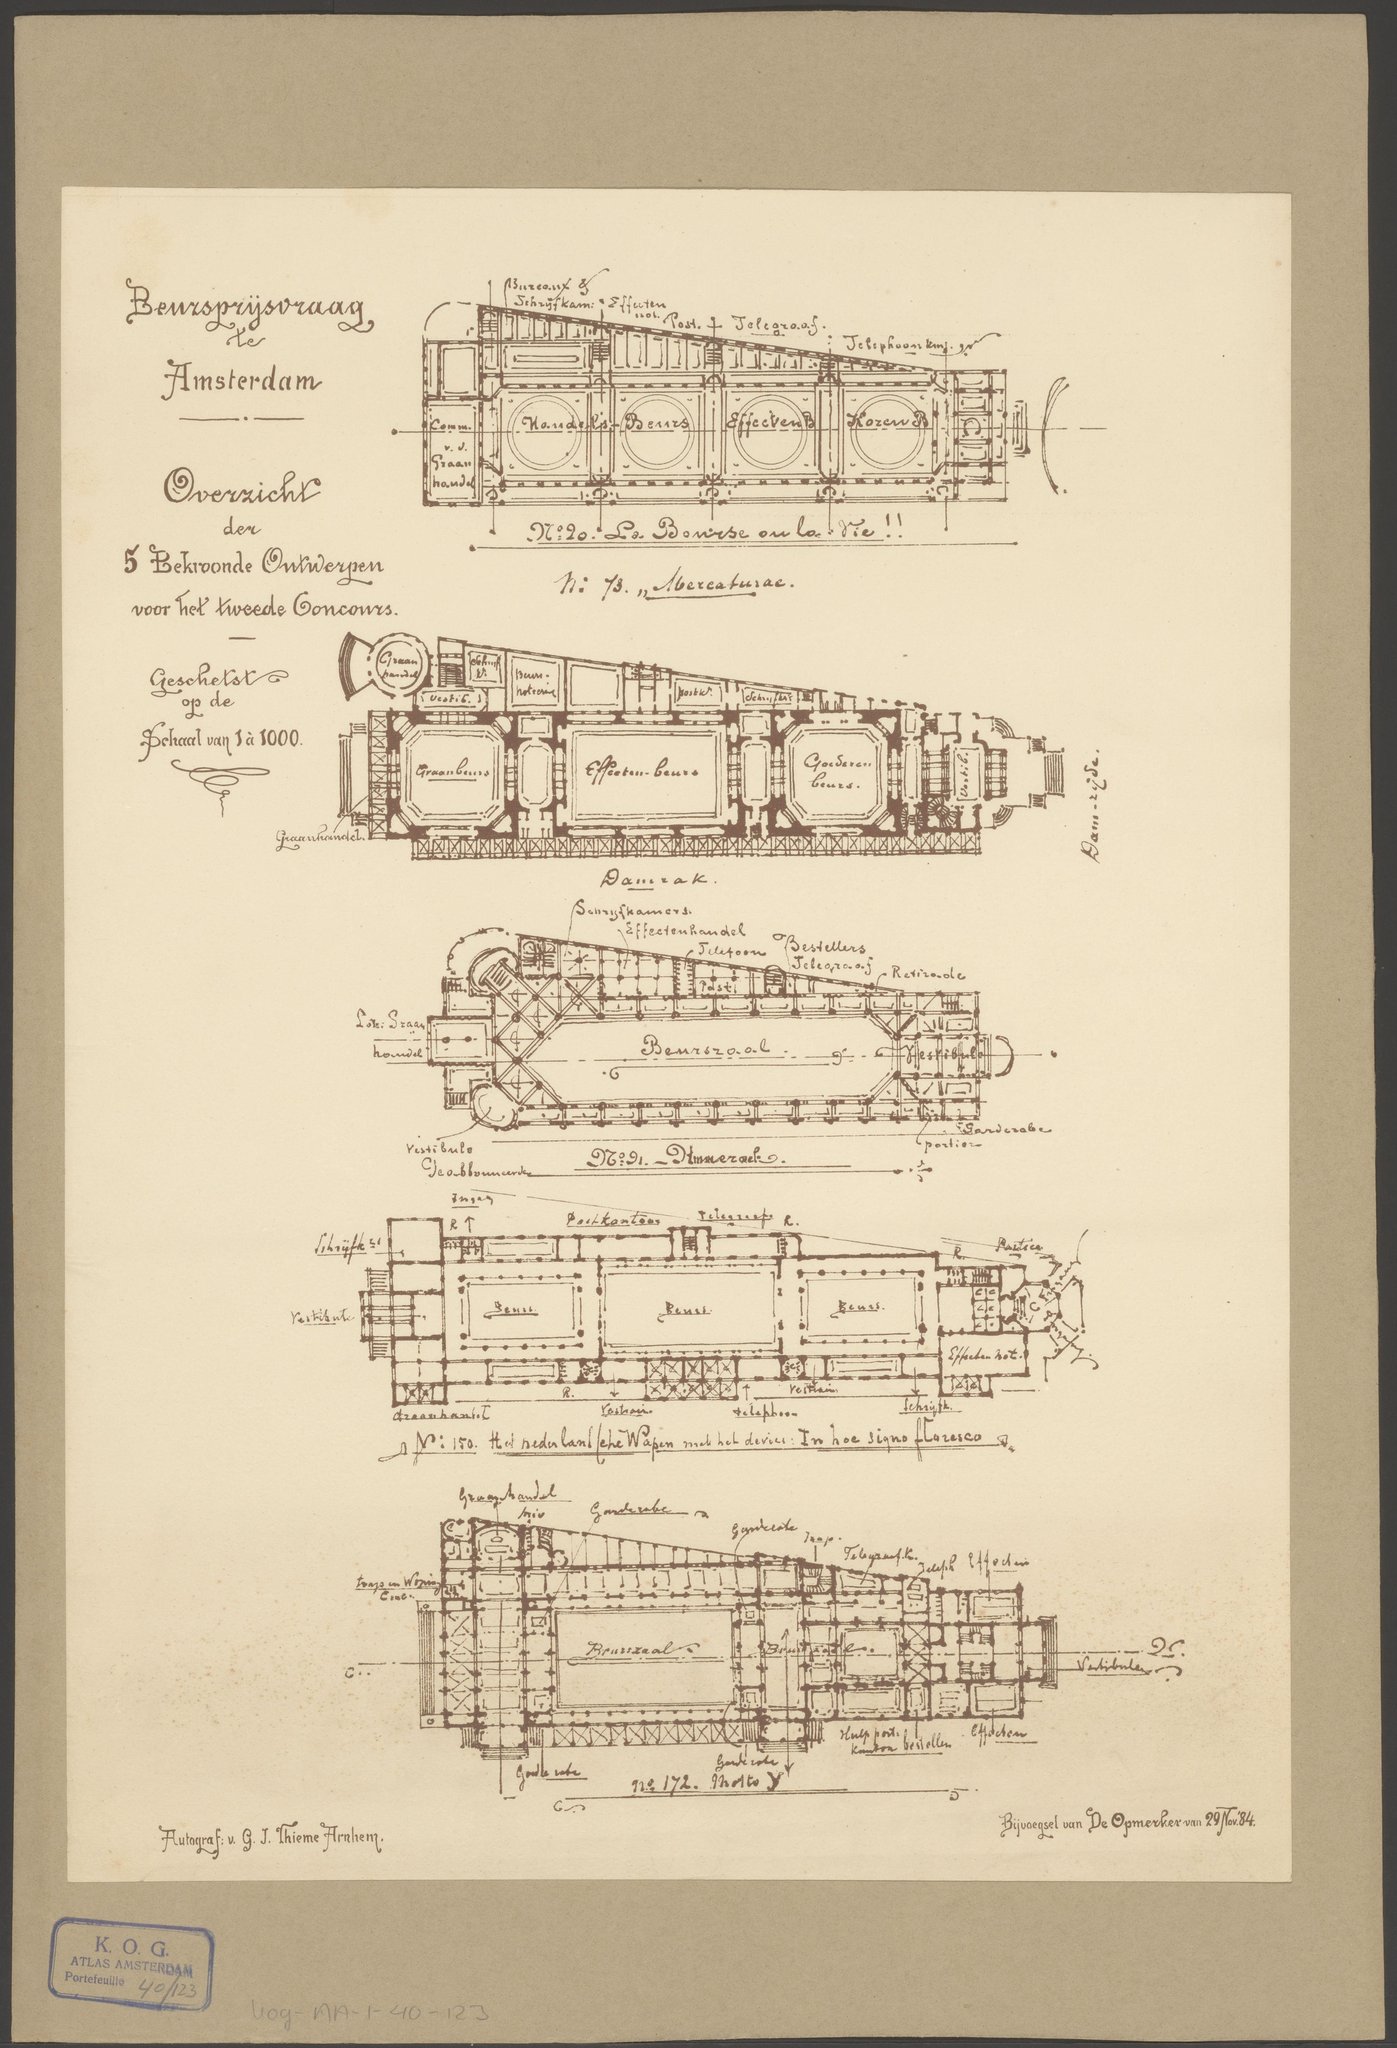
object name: photomechanical print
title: Beursprijsvraag te Amsterdam / Overzicht der 5 Bekroonde Ontwerpen voor het tweede Concours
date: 1884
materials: paper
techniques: photolithography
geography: arnhem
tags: stock exchange, stock-market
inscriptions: collector's mark: Lugt 1641b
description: Vijf plattegronden van de winnende ontwerpen voor de nieuwe beurs voor Amsterdam. Deze vijf ontwerpen mogen door naar de tweede ronde. Onderwerpsrubriek binnen de Atlas Amsterdam: Handel en Zeevaart, D. Beurs-Ontwerpen.